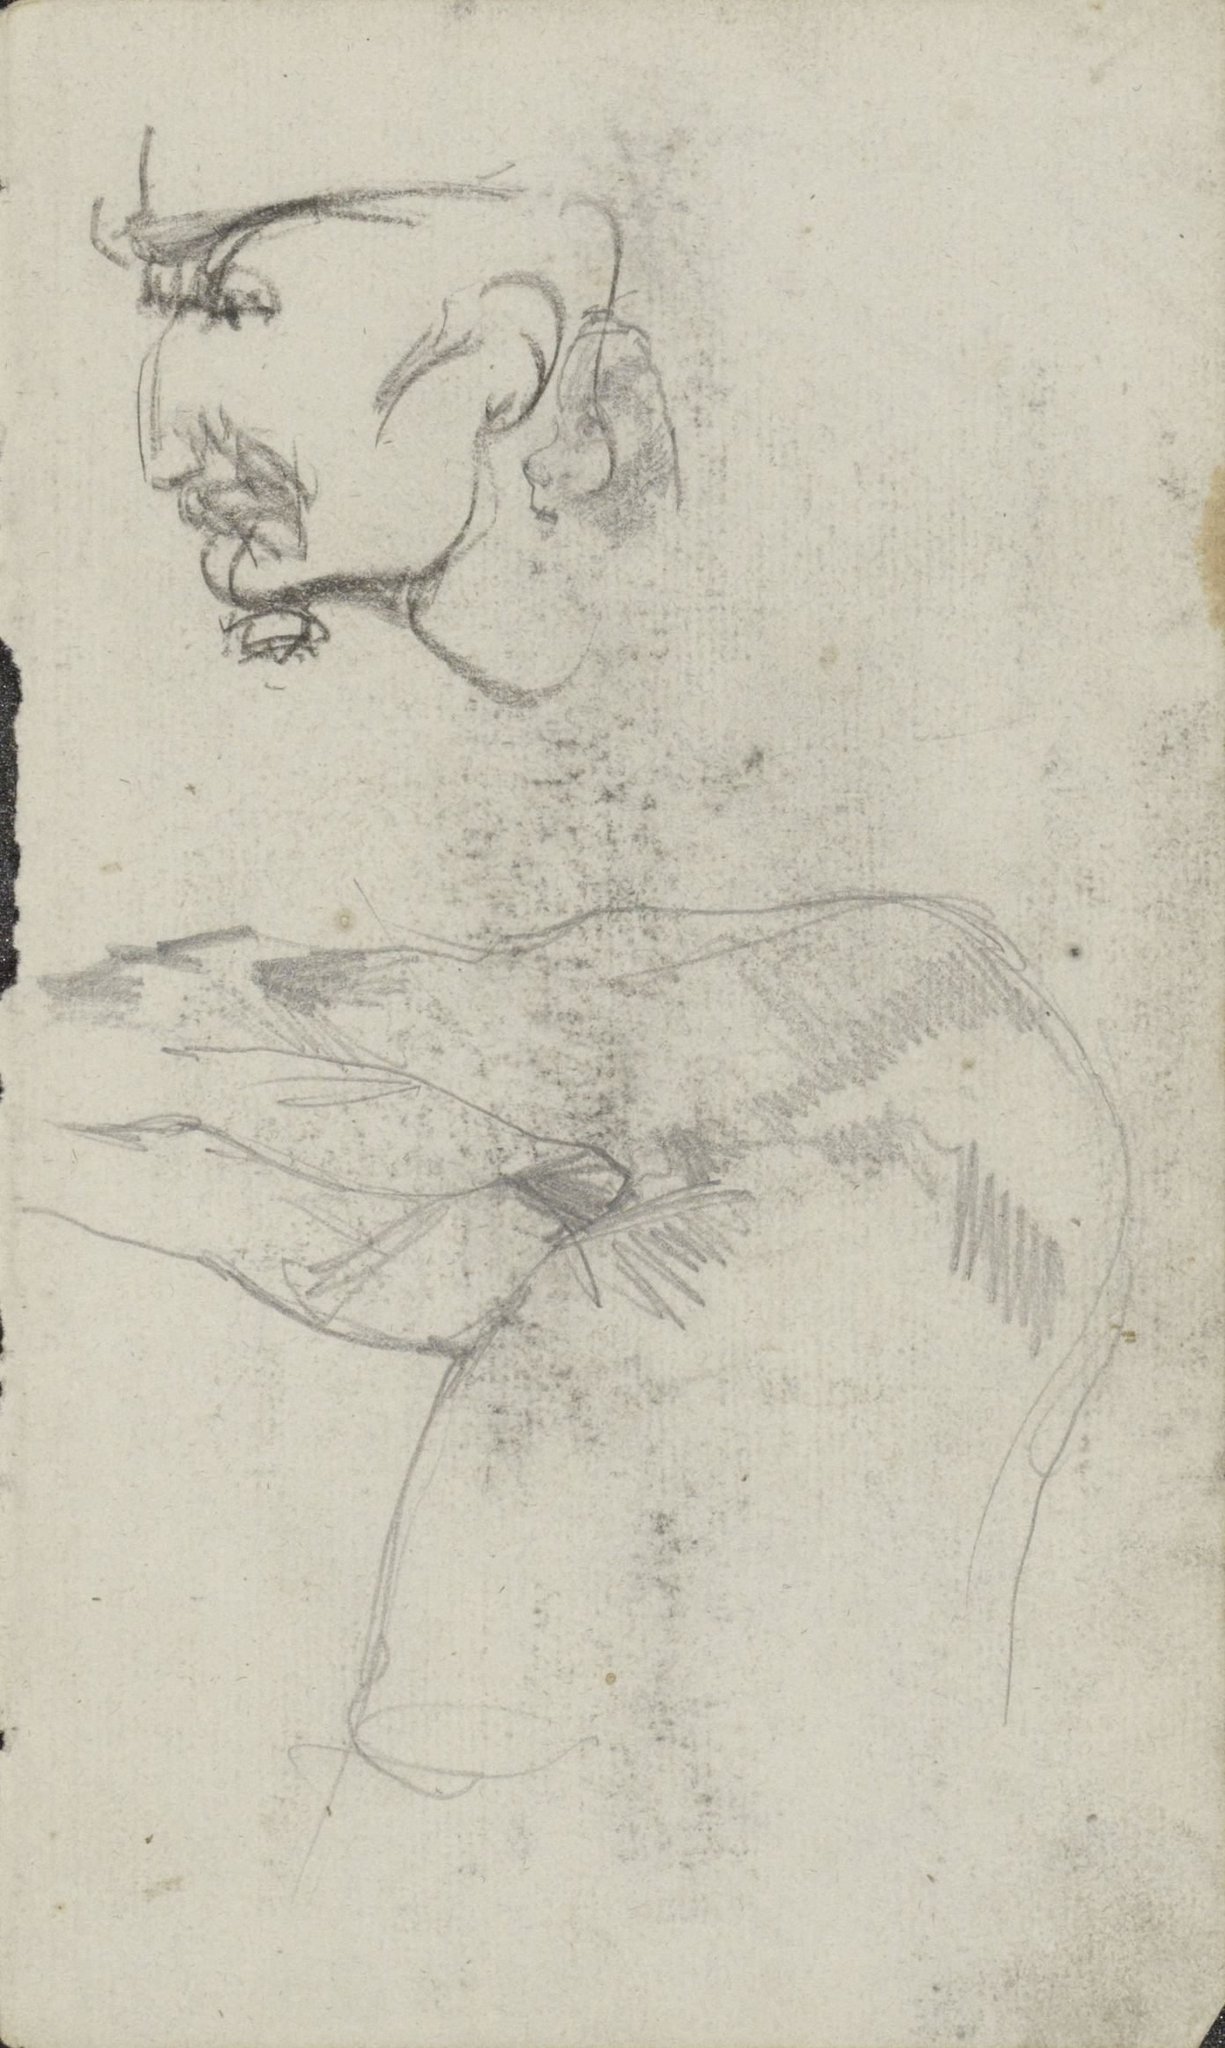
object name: drawing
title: Achterlijf van een paard en een mannenhoofd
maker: george hendrik breitner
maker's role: draughtsman, painter, print maker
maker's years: 1857-1923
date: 1882-1912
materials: chalk, paper, pencil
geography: netherlands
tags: head (human) (+ sideview, profile), horse